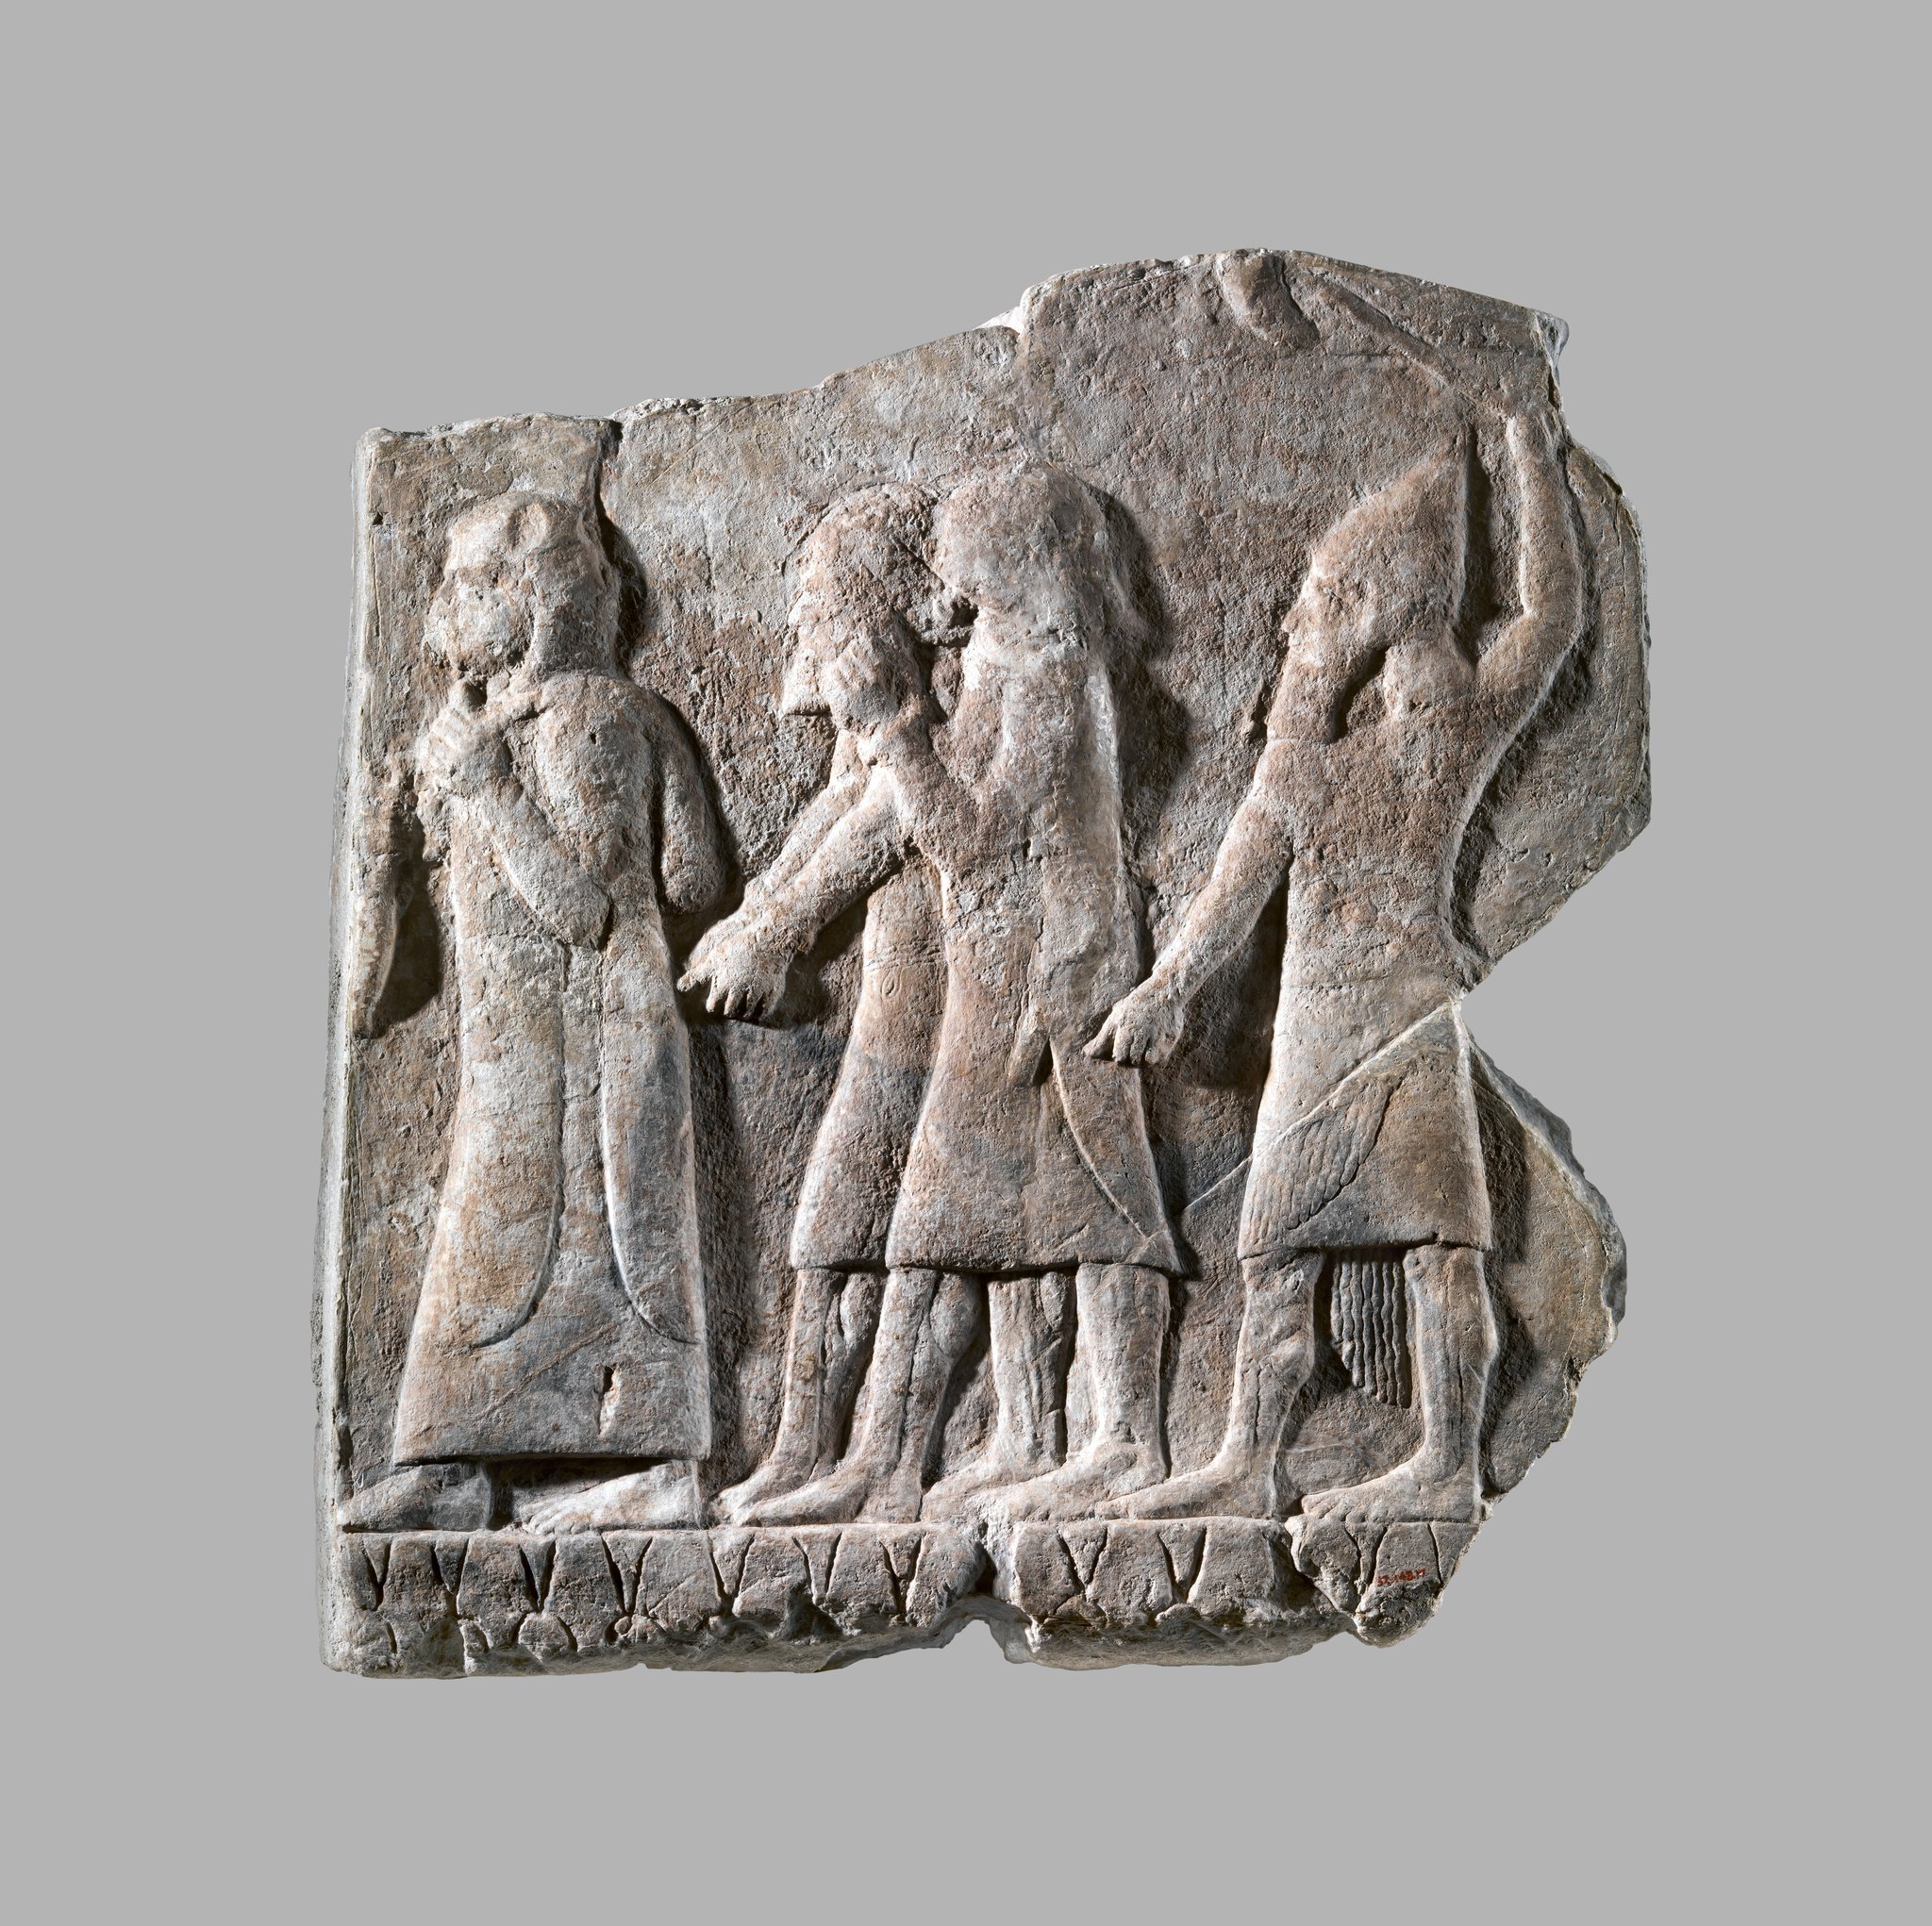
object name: relief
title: Relief: procession of captives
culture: assyrian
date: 704-681 BCE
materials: alabaster, gypsum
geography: mesopotamia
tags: men,women